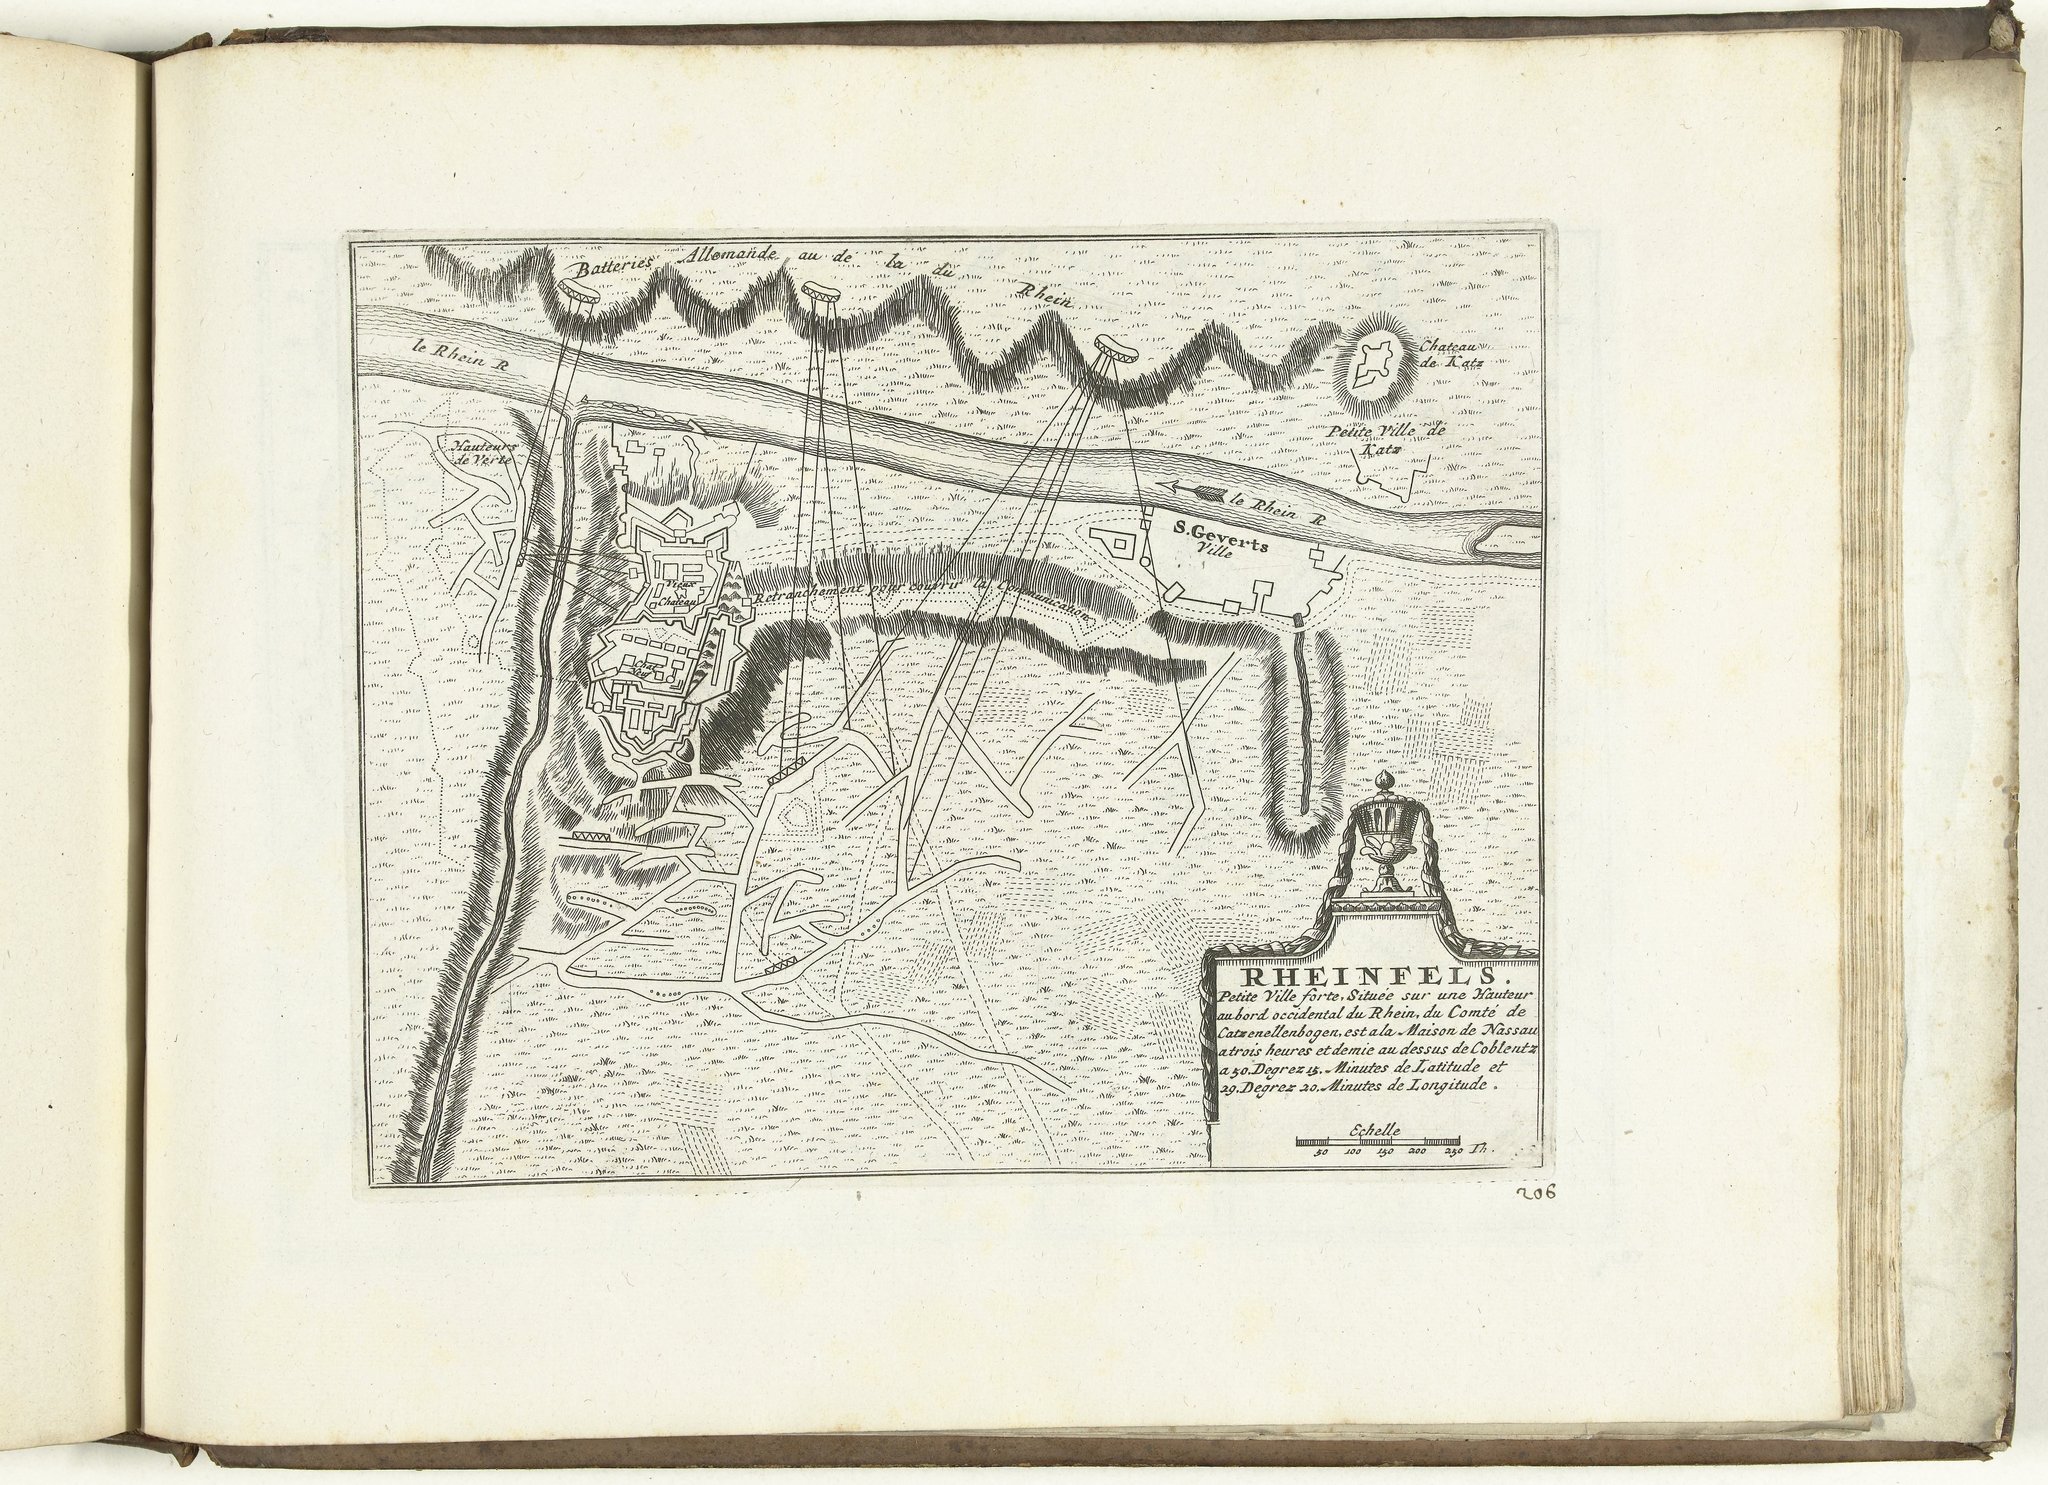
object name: map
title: Les Forces de l'Europe, Asie, Afrique et Amerique (...) Comme aussi les Cartes des Côtes de France et d'Espagne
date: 1726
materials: paper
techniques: etching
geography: leiden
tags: raising the siege with outside assistance, relief, maps of cities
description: Plattegrond met het ontzet van Rheinfels (dat belegerd werd door de Fransen) door Duitse troepen, januari 1693. Plaat nr. 206 in deel IX van het prentwerk: Les Forces de l'Europe, Asie, Afrique et Amerique ... Comme aussi les Cartes des Côtes de France et d'Espagne uit 1726, dit eerste deel met 238 met de hand genummerde platen van vermaarde sterke steden en vestingen in het kader van de Spaanse Successieoorlog 1701-1713. Voor het merendeel zijn deze platen gekopieerd naar de anonieme Franse platen van vermaarde sterke steden en vestingen: in Les forces de l'Europe en in: Le theatre de la guerre, dans les Pays-Bas, beide oorspronkelijk uitgegeven door Nicolas de Fer te Parijs (1693-1697) in het kader van de Negenjarige Oorlog. Titel en opschriften in het Frans. Rechtsonder sporen van het weggepolijste nummer: 96.